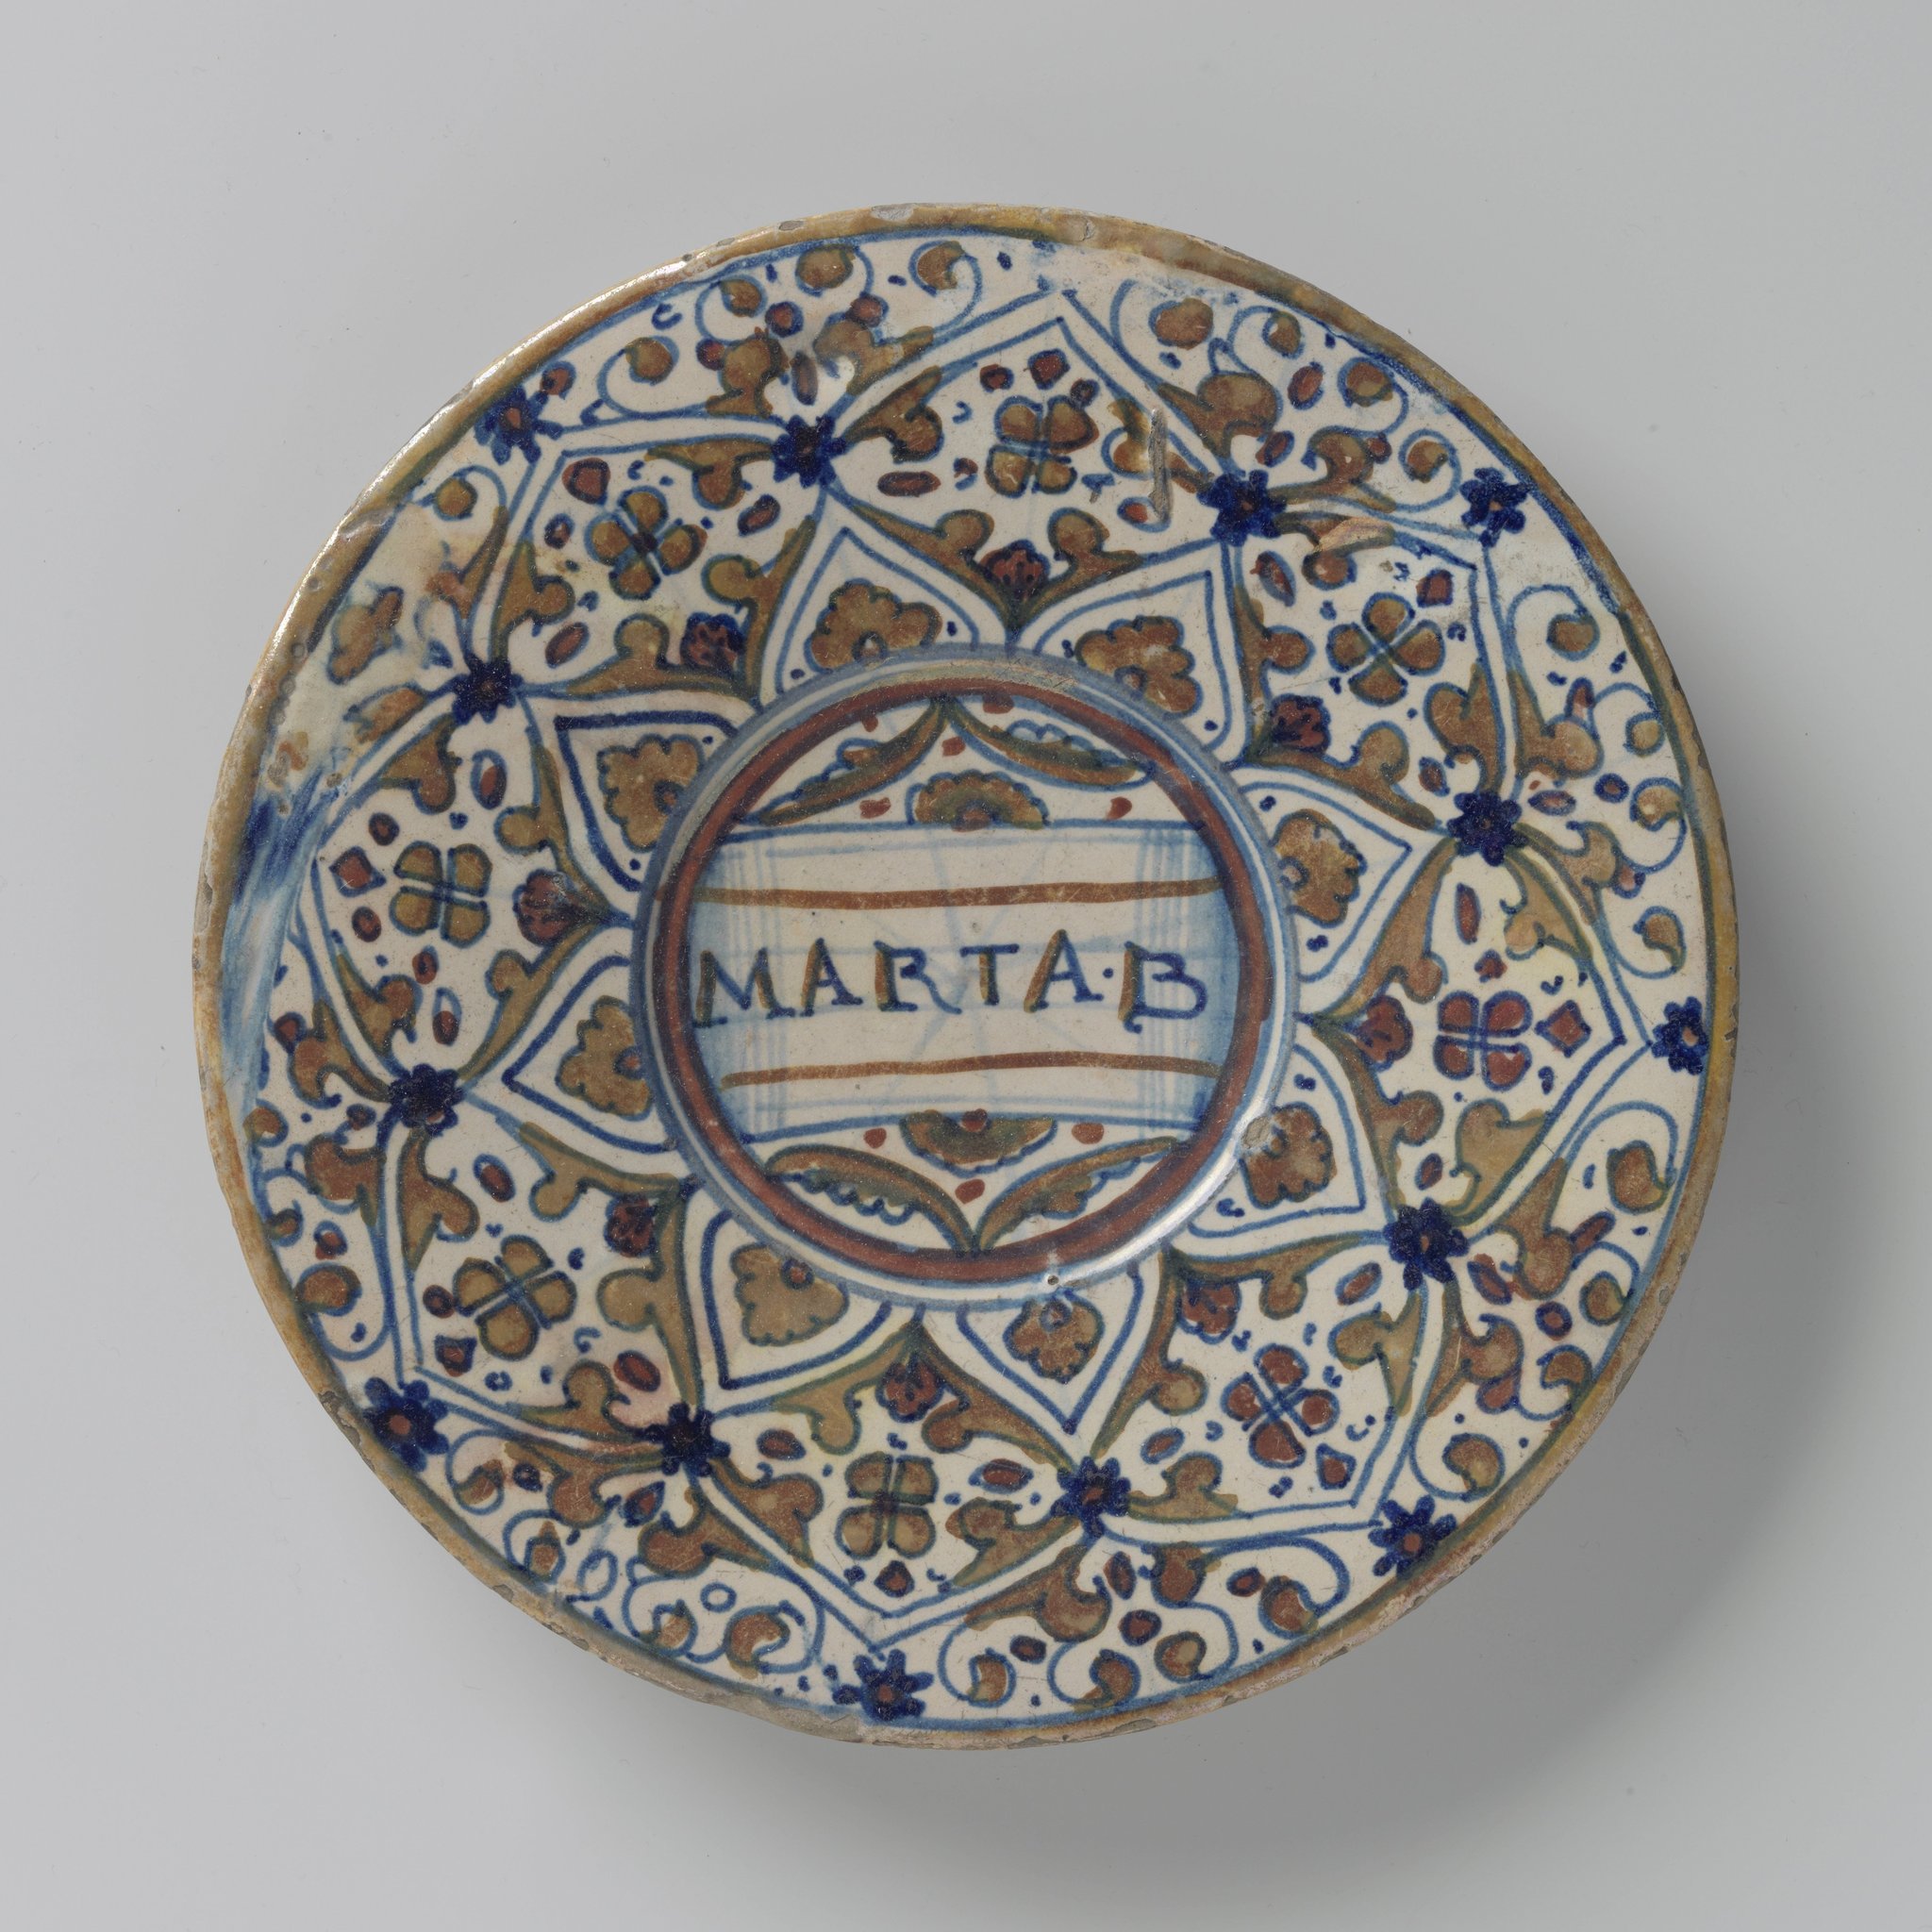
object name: plate dish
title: Bord, veelkleurig beschilderd met geronde ruitvormige vakken waarbinnen bladmotieven en met opschrift: MARTA.B.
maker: Anonymous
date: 1530-1540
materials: earthenware, glaze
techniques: maiolica, painted, polychromy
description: Plate. Maiolica. Gubbio, c. 1530 - 1540.